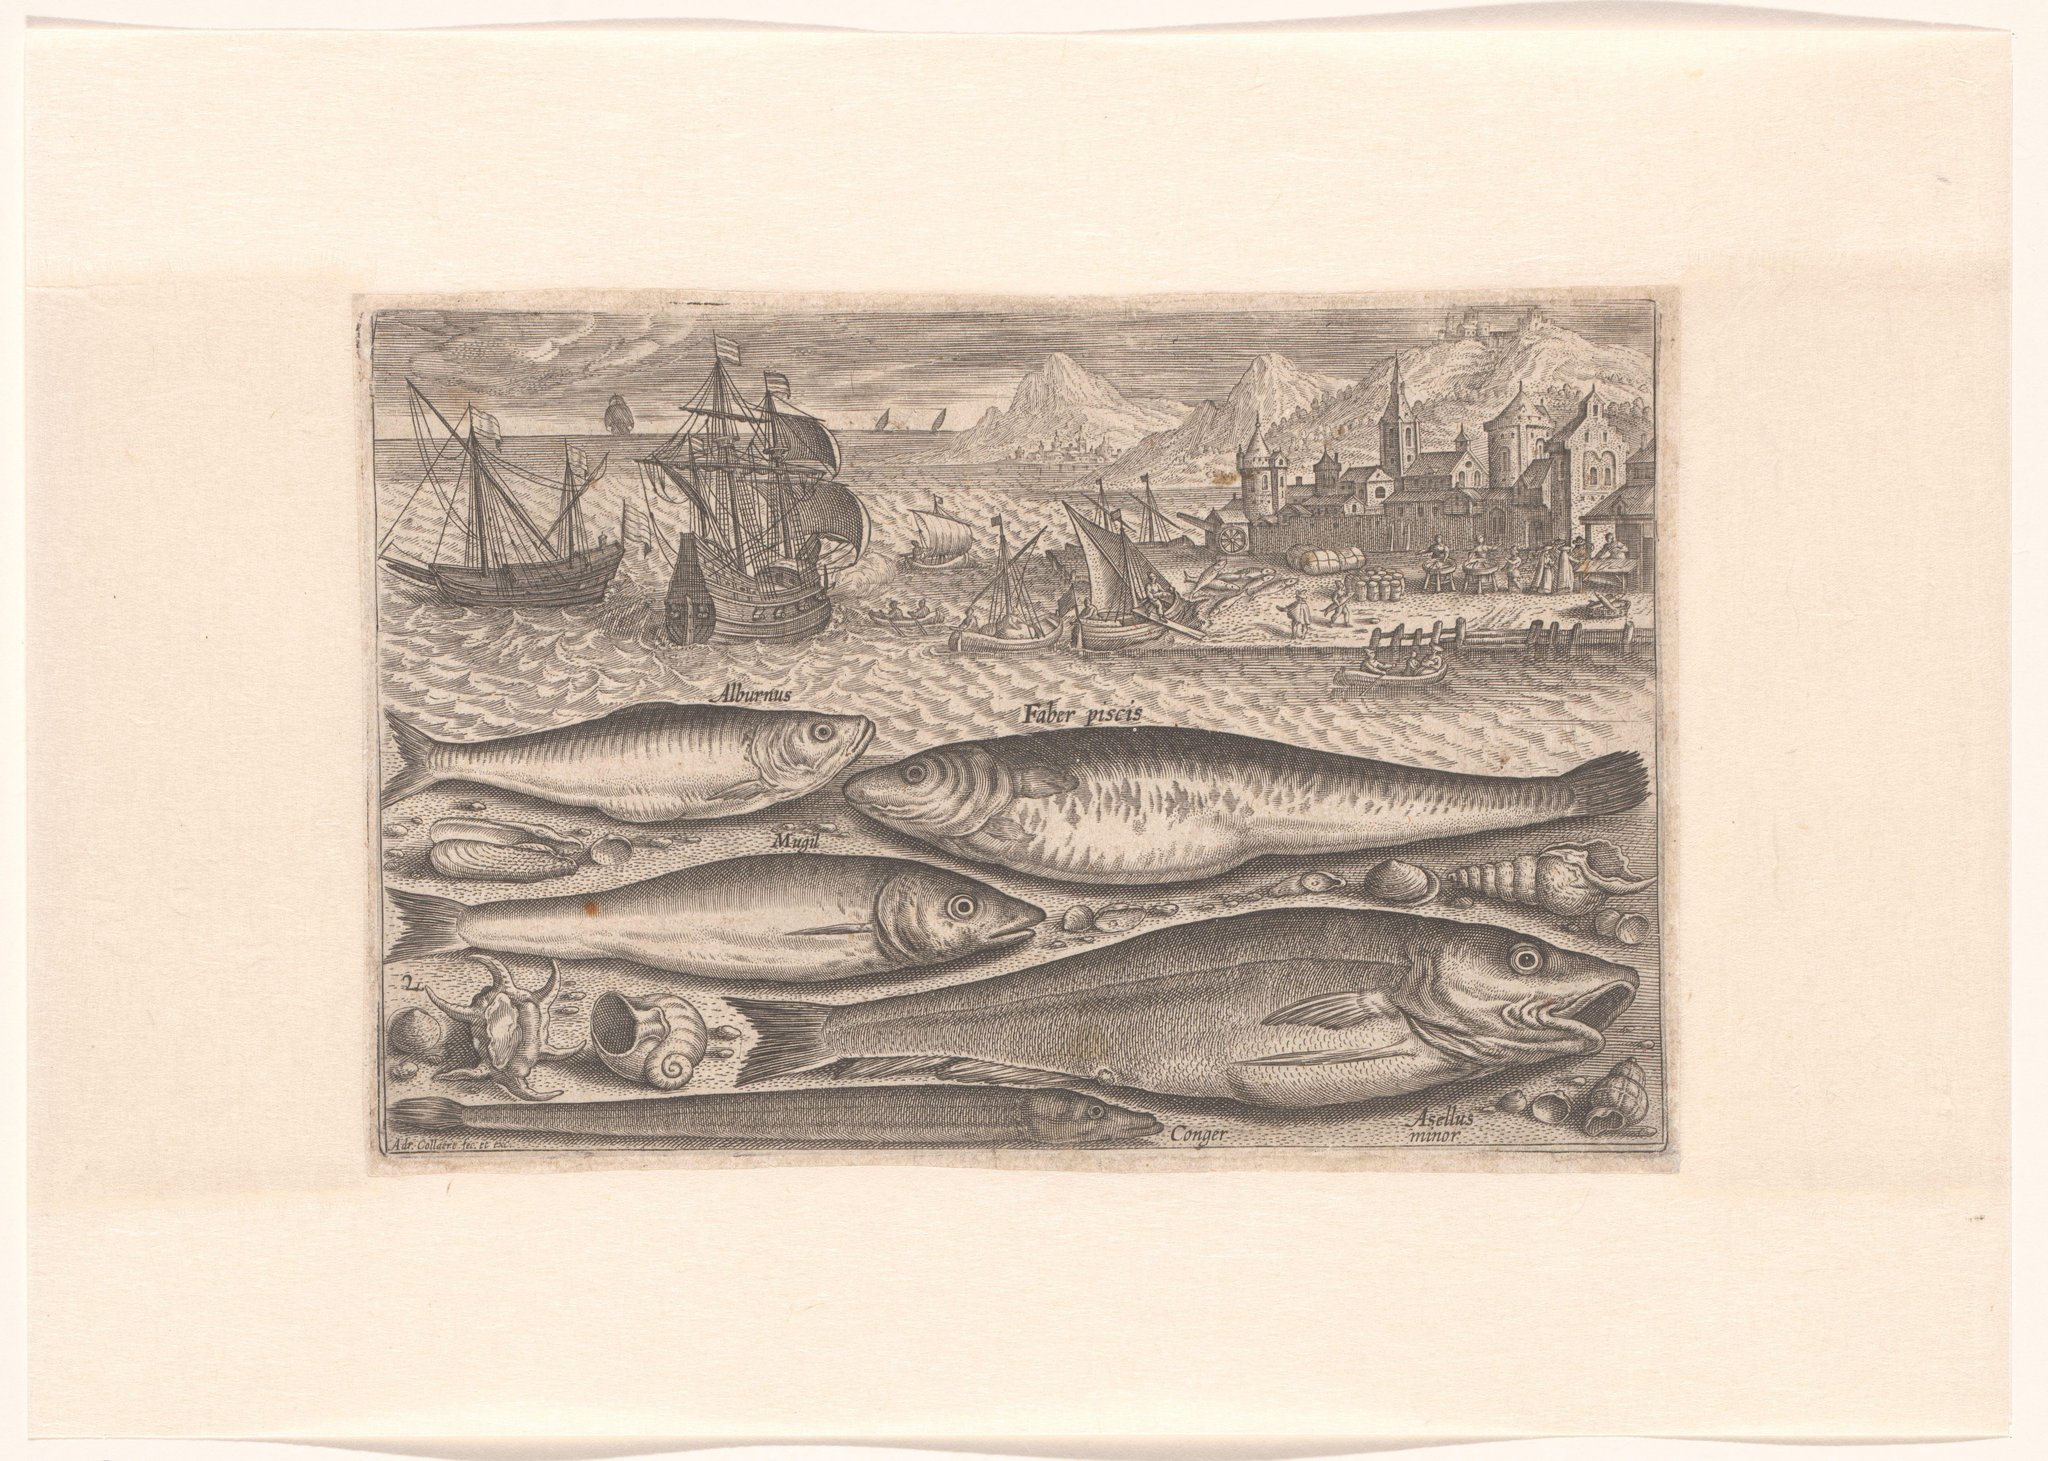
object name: print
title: Vissen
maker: adriaen collaert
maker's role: draughtsman, print maker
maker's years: 1560-1618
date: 1598-1618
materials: paper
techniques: engraving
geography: antwerp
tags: pier, quay, wharf, bony fishes: carp, bony fishes: cod, bony fishes: sprat, bony fishes: mullet, eels: eel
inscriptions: collector's mark: Lugt 2228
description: Een sprot, een karper, een harder, een kleine kabeljauw en een zeepaling liggen samen met wat schelpen aangespoeld op het strand. Op de achtergrond de zee en een havenkade. De prent maakt deel uit van een serie met vissen als onderwerp.